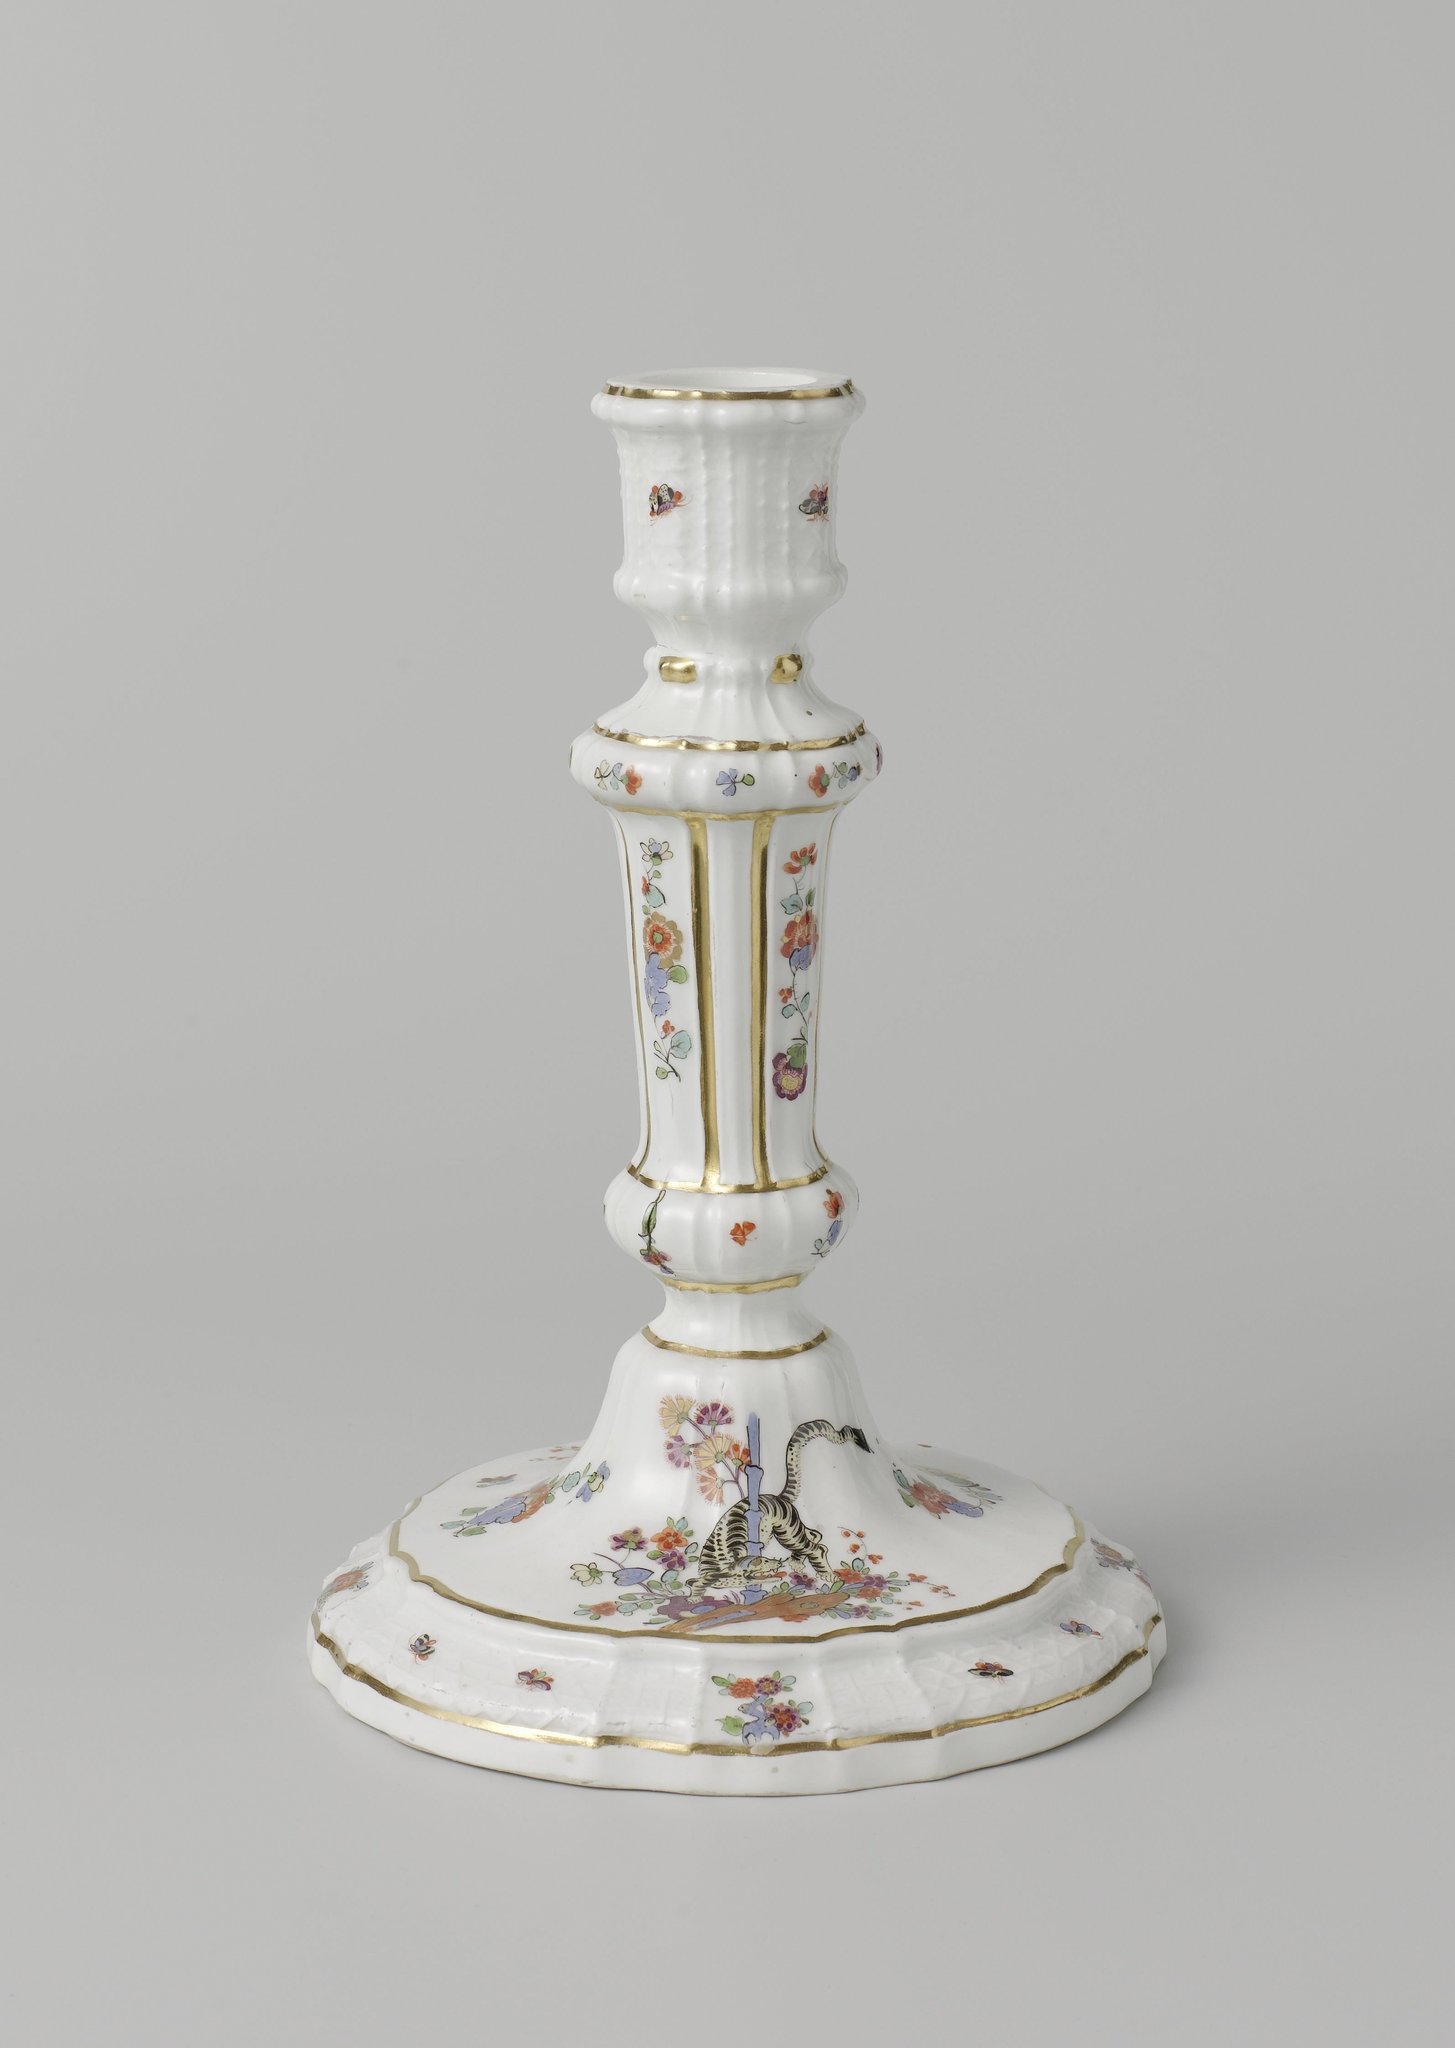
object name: candlestick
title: Kandelaar, veelkleurig beschilderd met een Kakiemon-decor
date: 1740-1745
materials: porcelain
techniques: painted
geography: meissen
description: Kandelaar van beschilderd porselein. De kandelaar heeft een ronde, geschulpte voet met een geprofileerde stam met twee nodi. Op de kaarsenhouder en de voetrand is het 'Altbrandenstein'-patroon geschilderd. Op de voet is een tijger om een bamboestengel in bloemen geschilderd. De kandelaar is gemerkt.